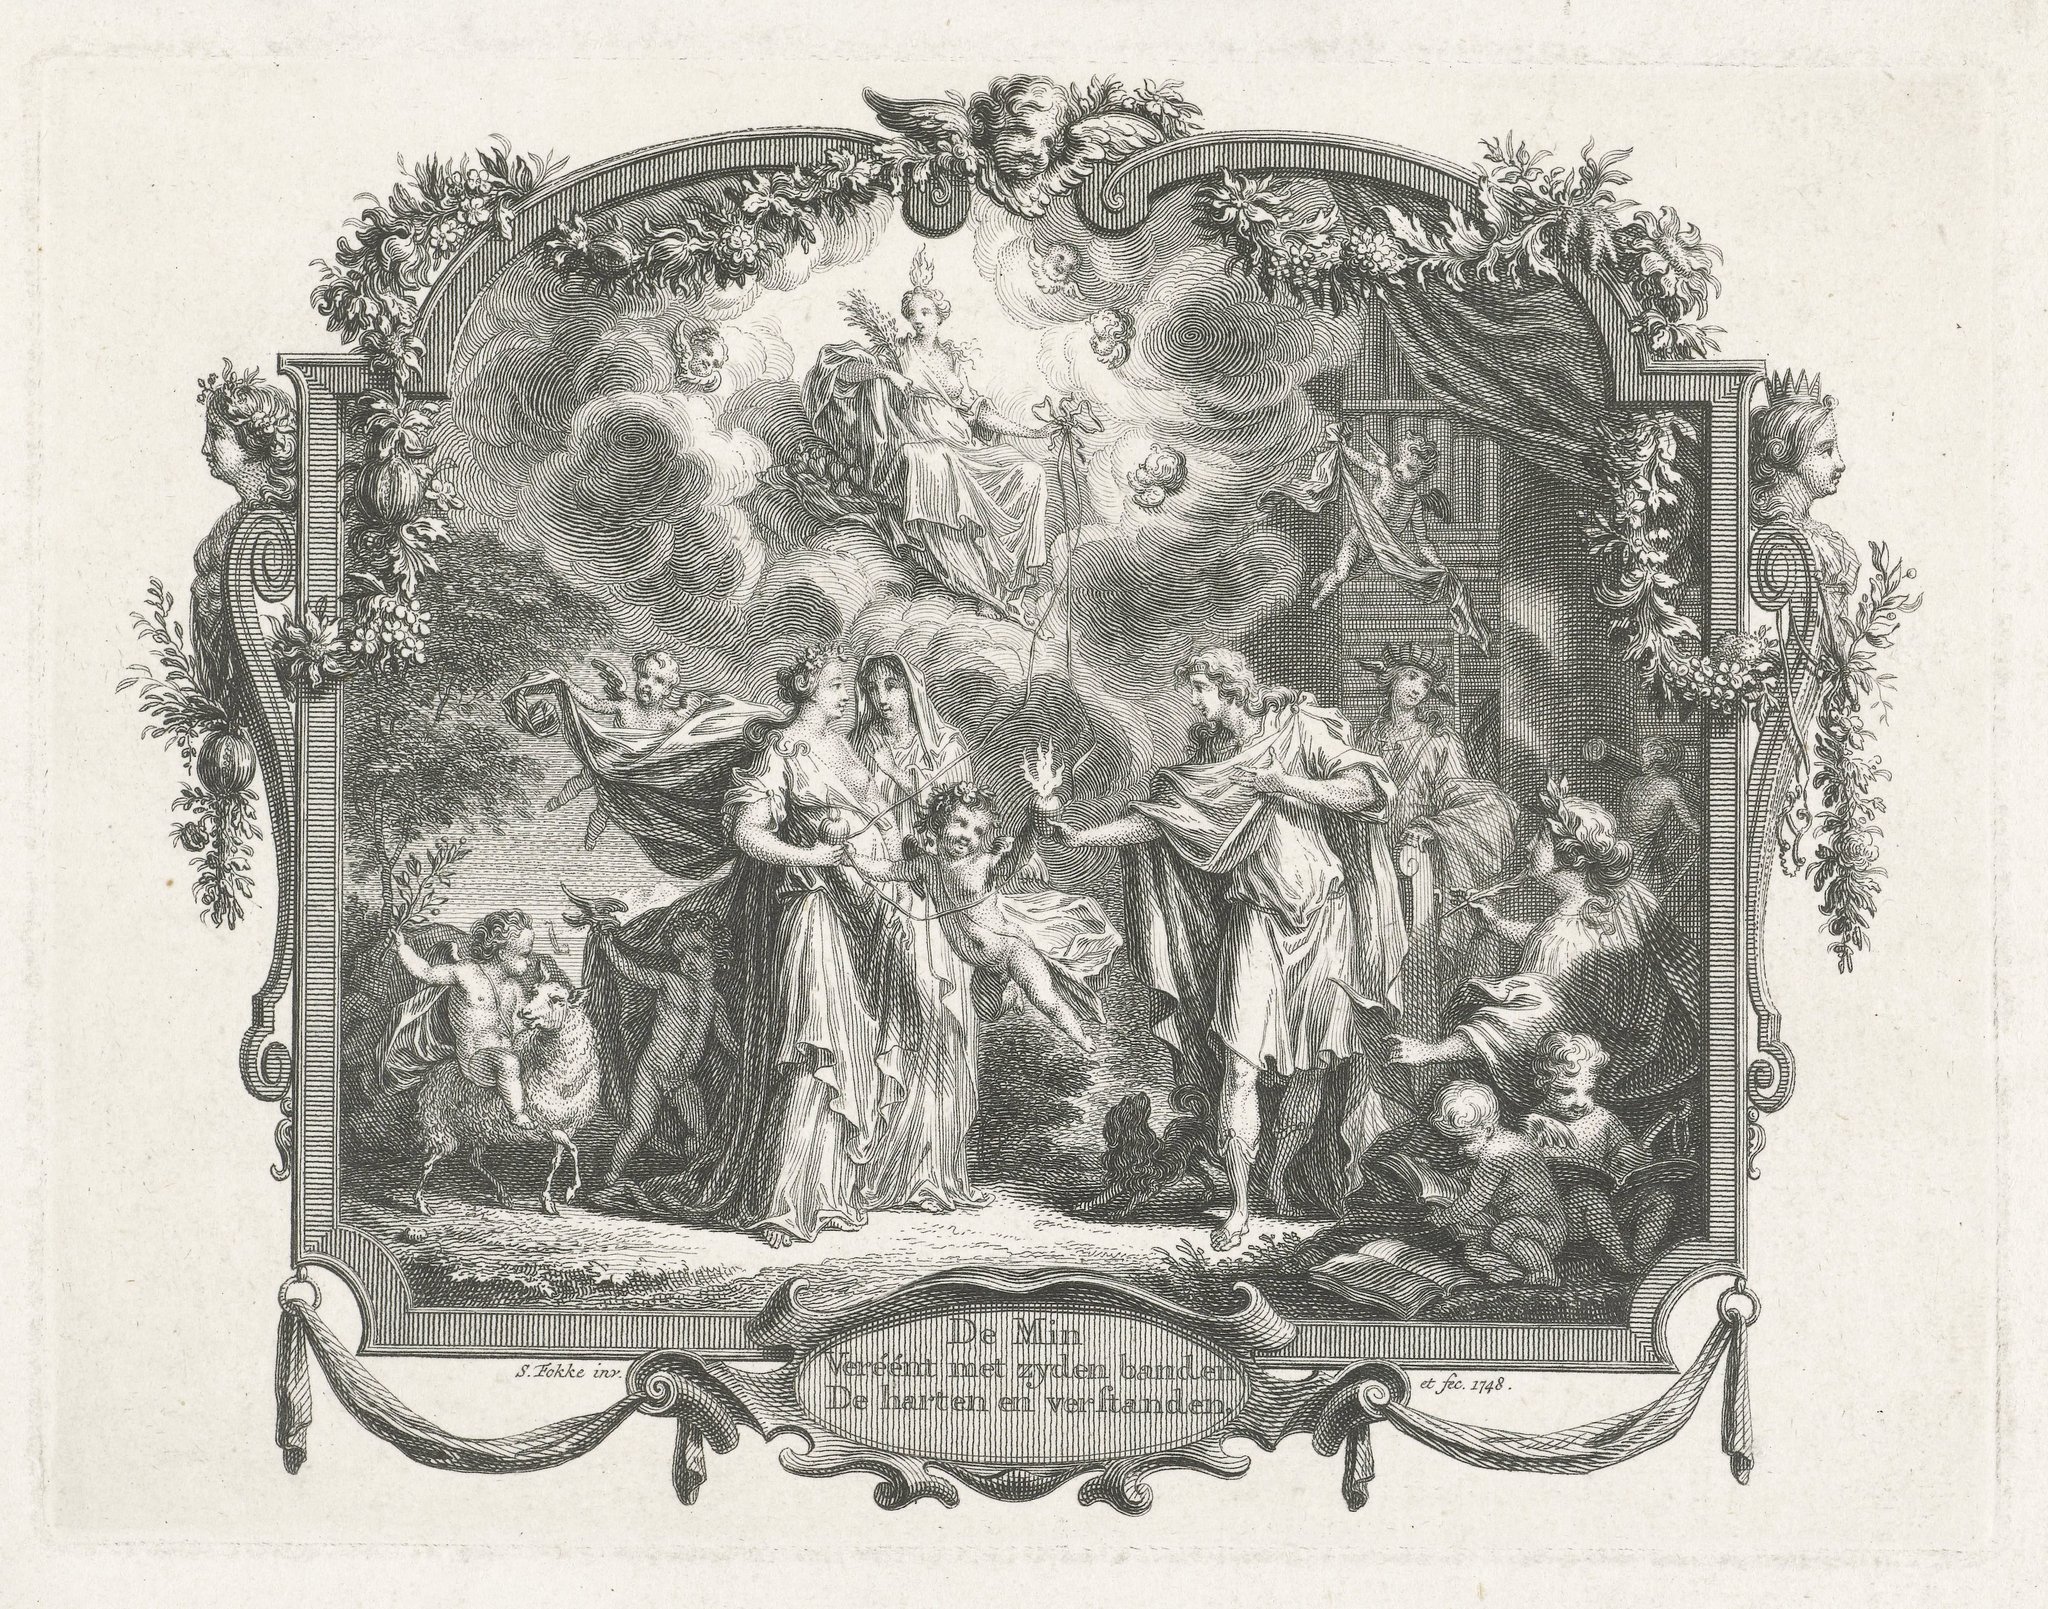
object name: print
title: De Min veréént met zyden banden, De harten en verstanden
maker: simon fokke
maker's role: draughtsman, print maker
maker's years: 1712-1784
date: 1748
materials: paper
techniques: etching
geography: amsterdam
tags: 'castità matrimoniale', 'fede maritale', 'matrimonio' (ripa)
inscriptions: collector's mark: Lugt 2228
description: Een echtpaar wordt door een in de wolken gezeten allegorische vrouwenfiguur in de echt verbonden. De man en vrouw dragen beiden een brandend hart in de handen en worden bijgestaan door allegorische figuren en putti. De voorstelling is omkaderd met een ornamentele lijst.